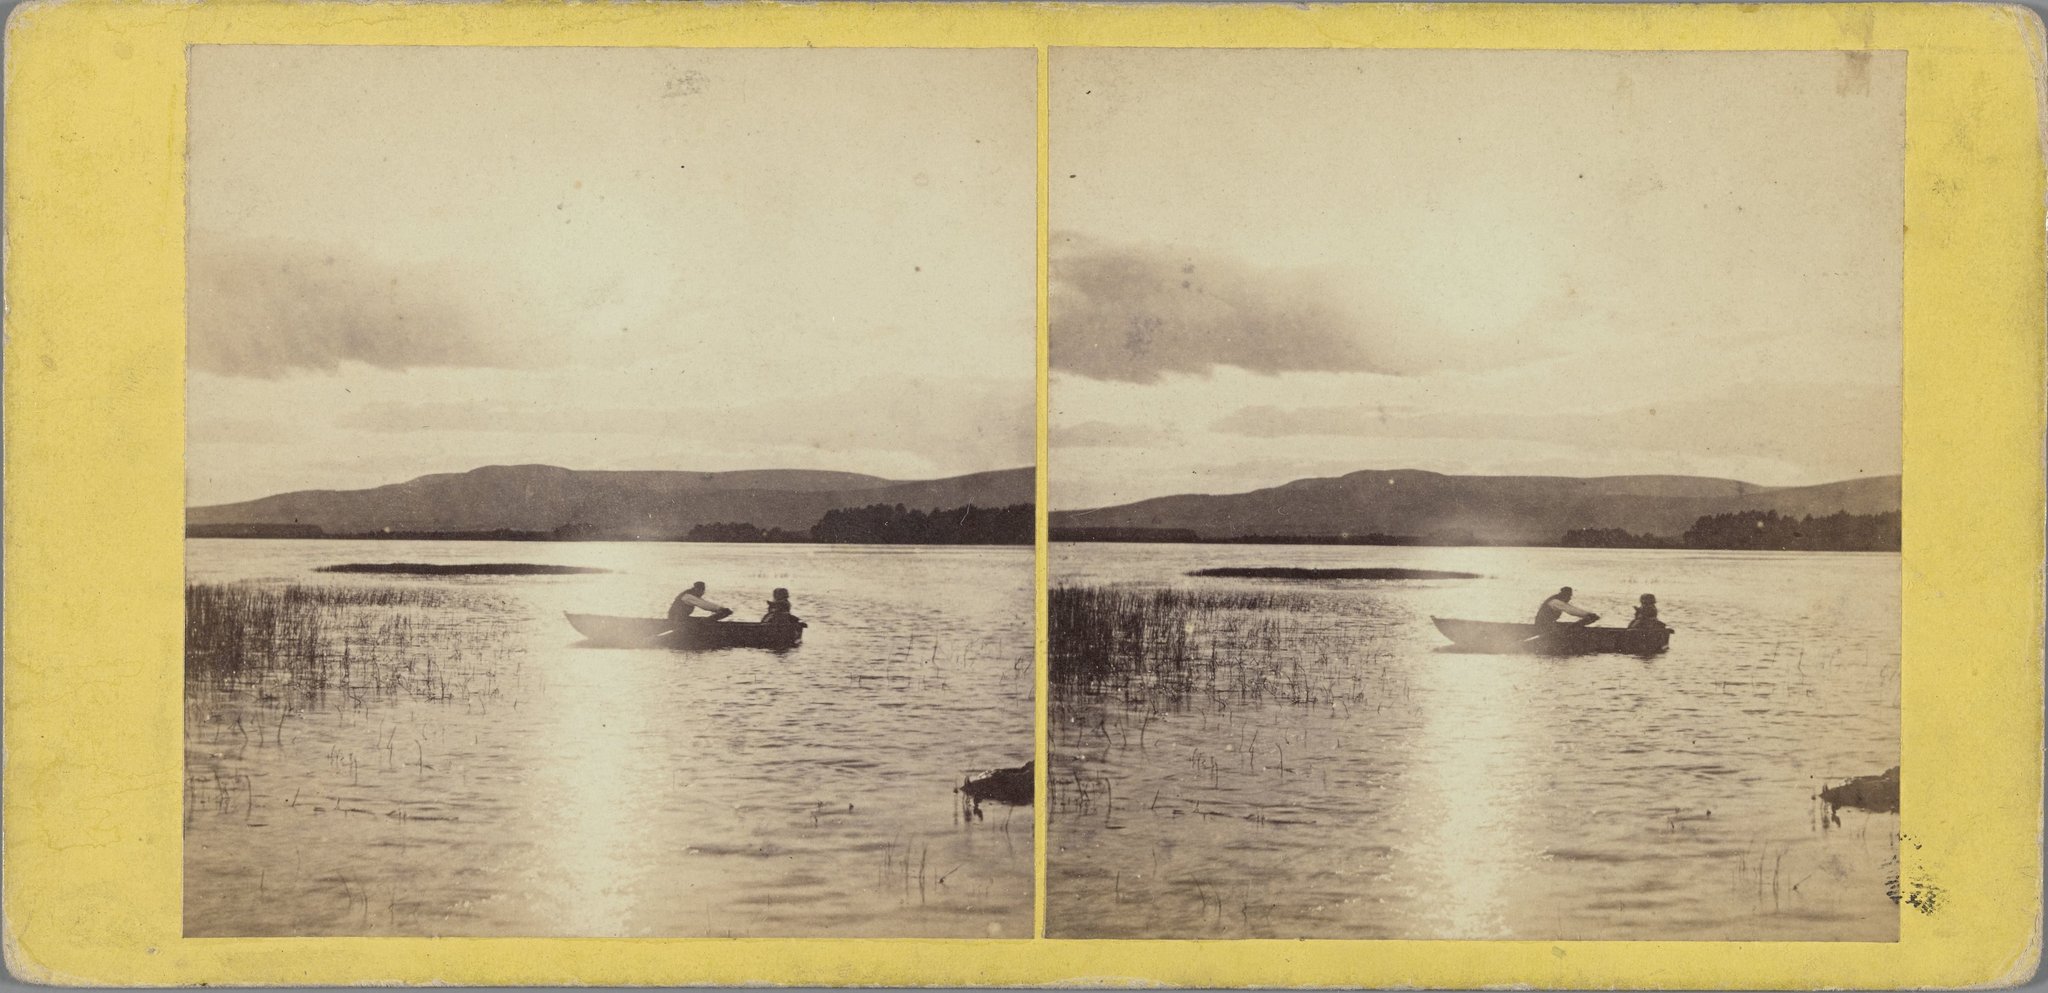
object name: stereograph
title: Twee personen in een roeiboot op het Loch of Park in Aberdeenshire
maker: george washington wilson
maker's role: publisher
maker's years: 1823-1893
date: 1859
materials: cardboard, paper, photographic support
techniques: albumen print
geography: aberdeenshire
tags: rowing-boat, canoe, etc., lake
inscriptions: inscription: ‘The Loch of Park, Aberdeenshire No. 125’